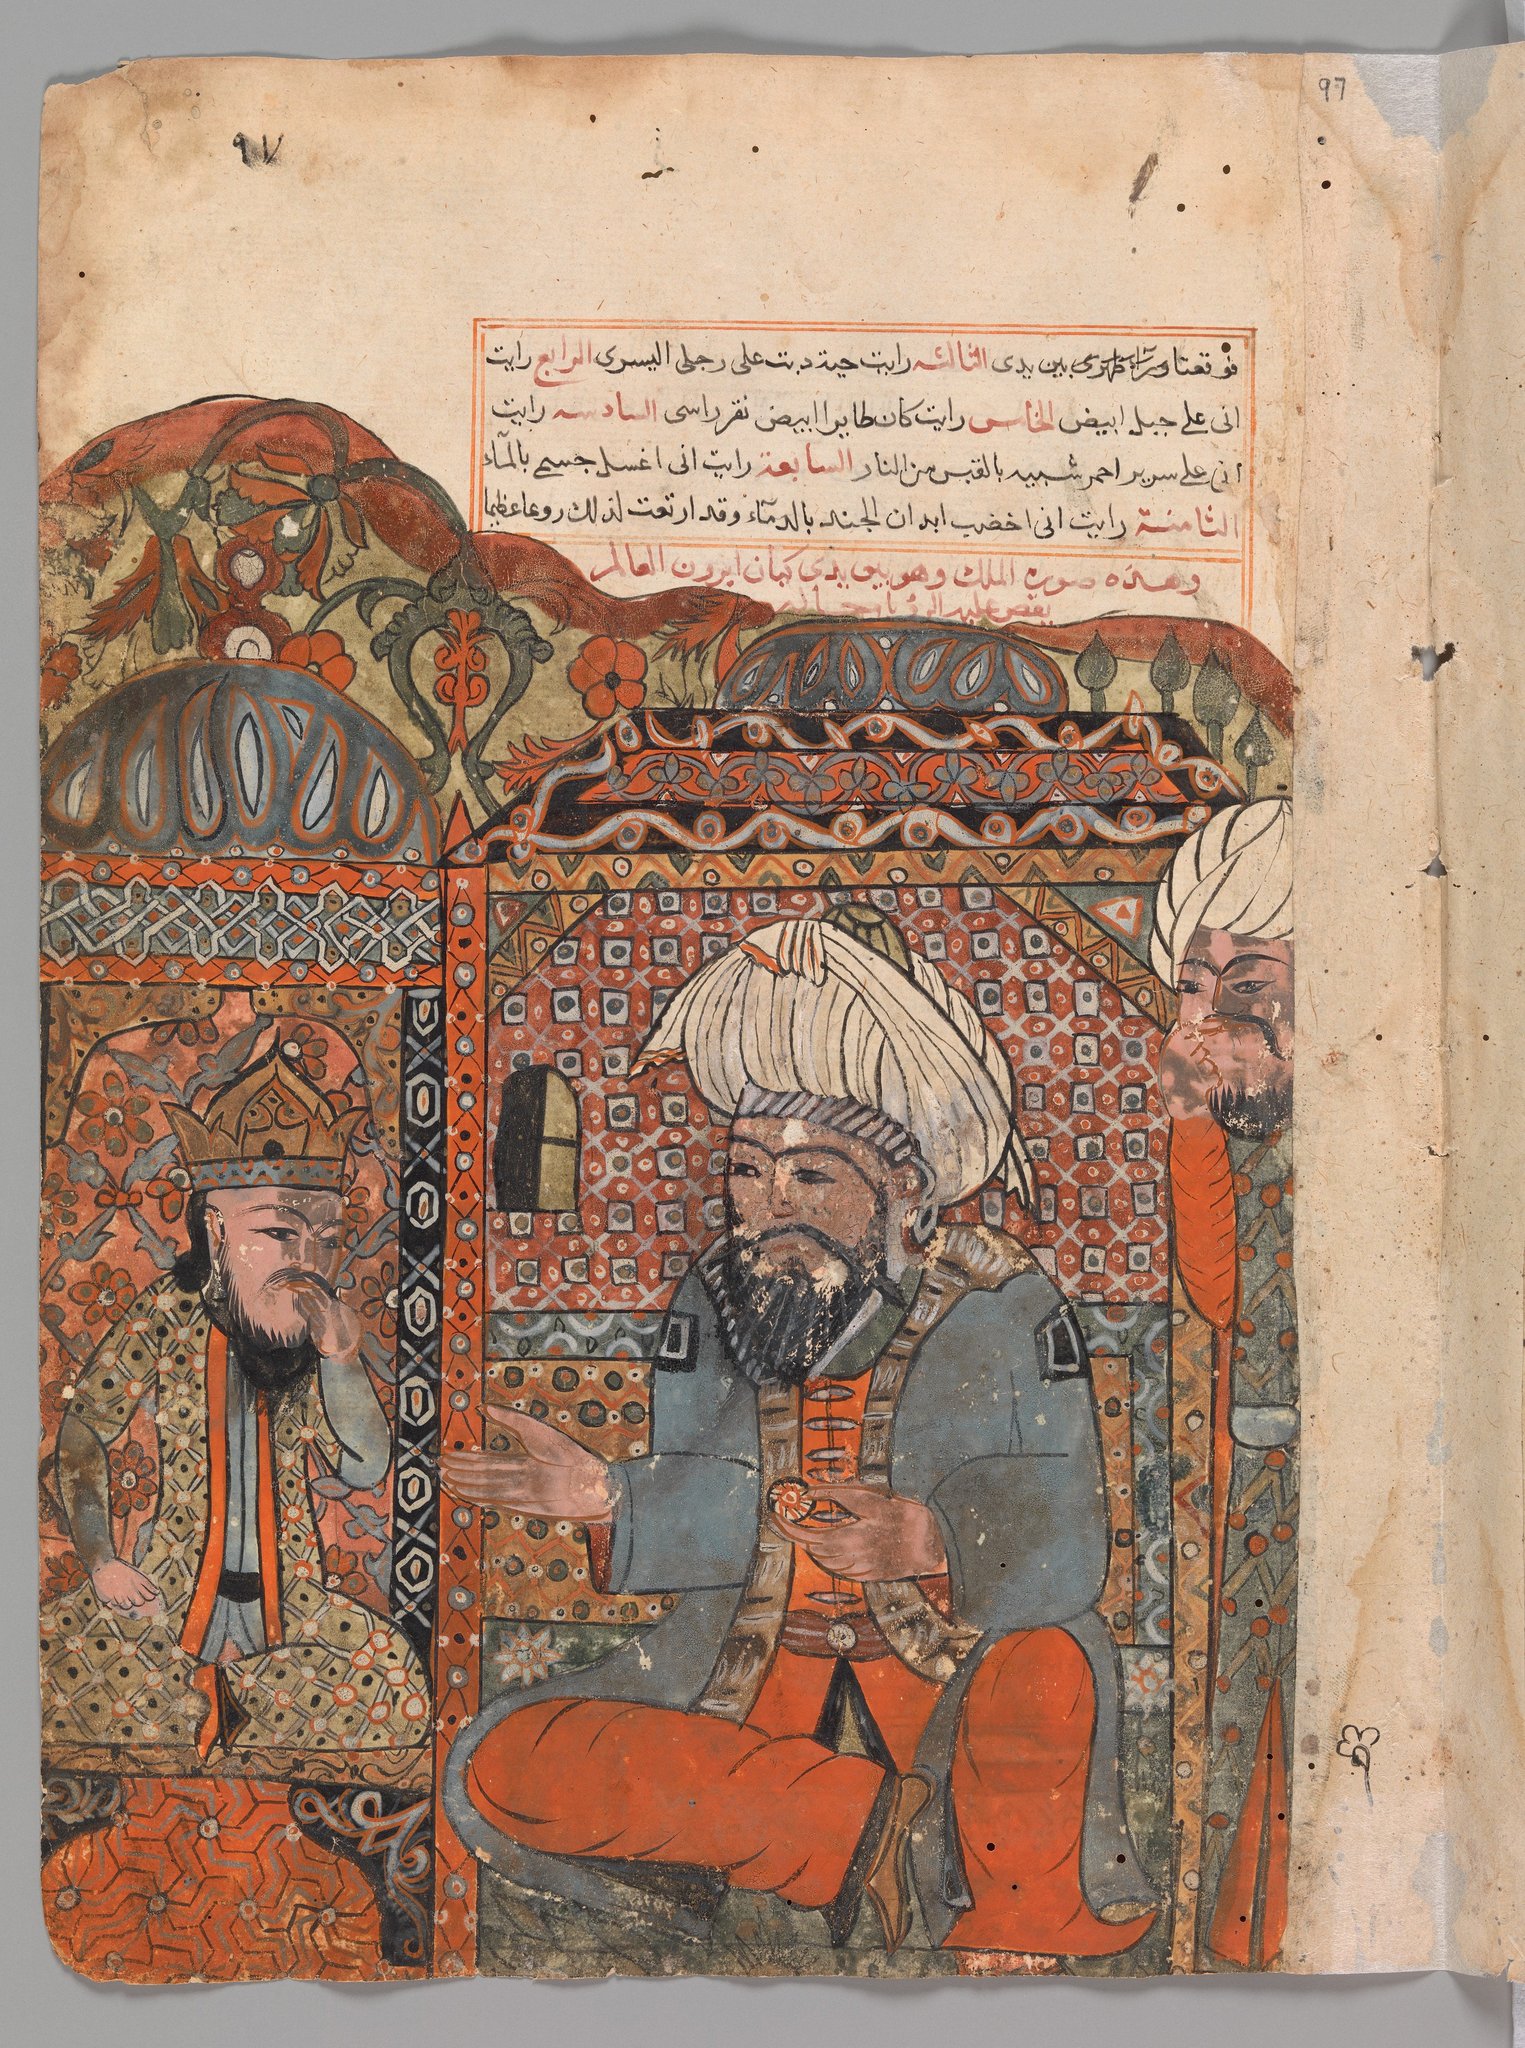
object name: folio from an illustrated manuscript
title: Folio from a Kalila wa Dimna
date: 1526-1550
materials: ink, paper, watercolor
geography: india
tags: men